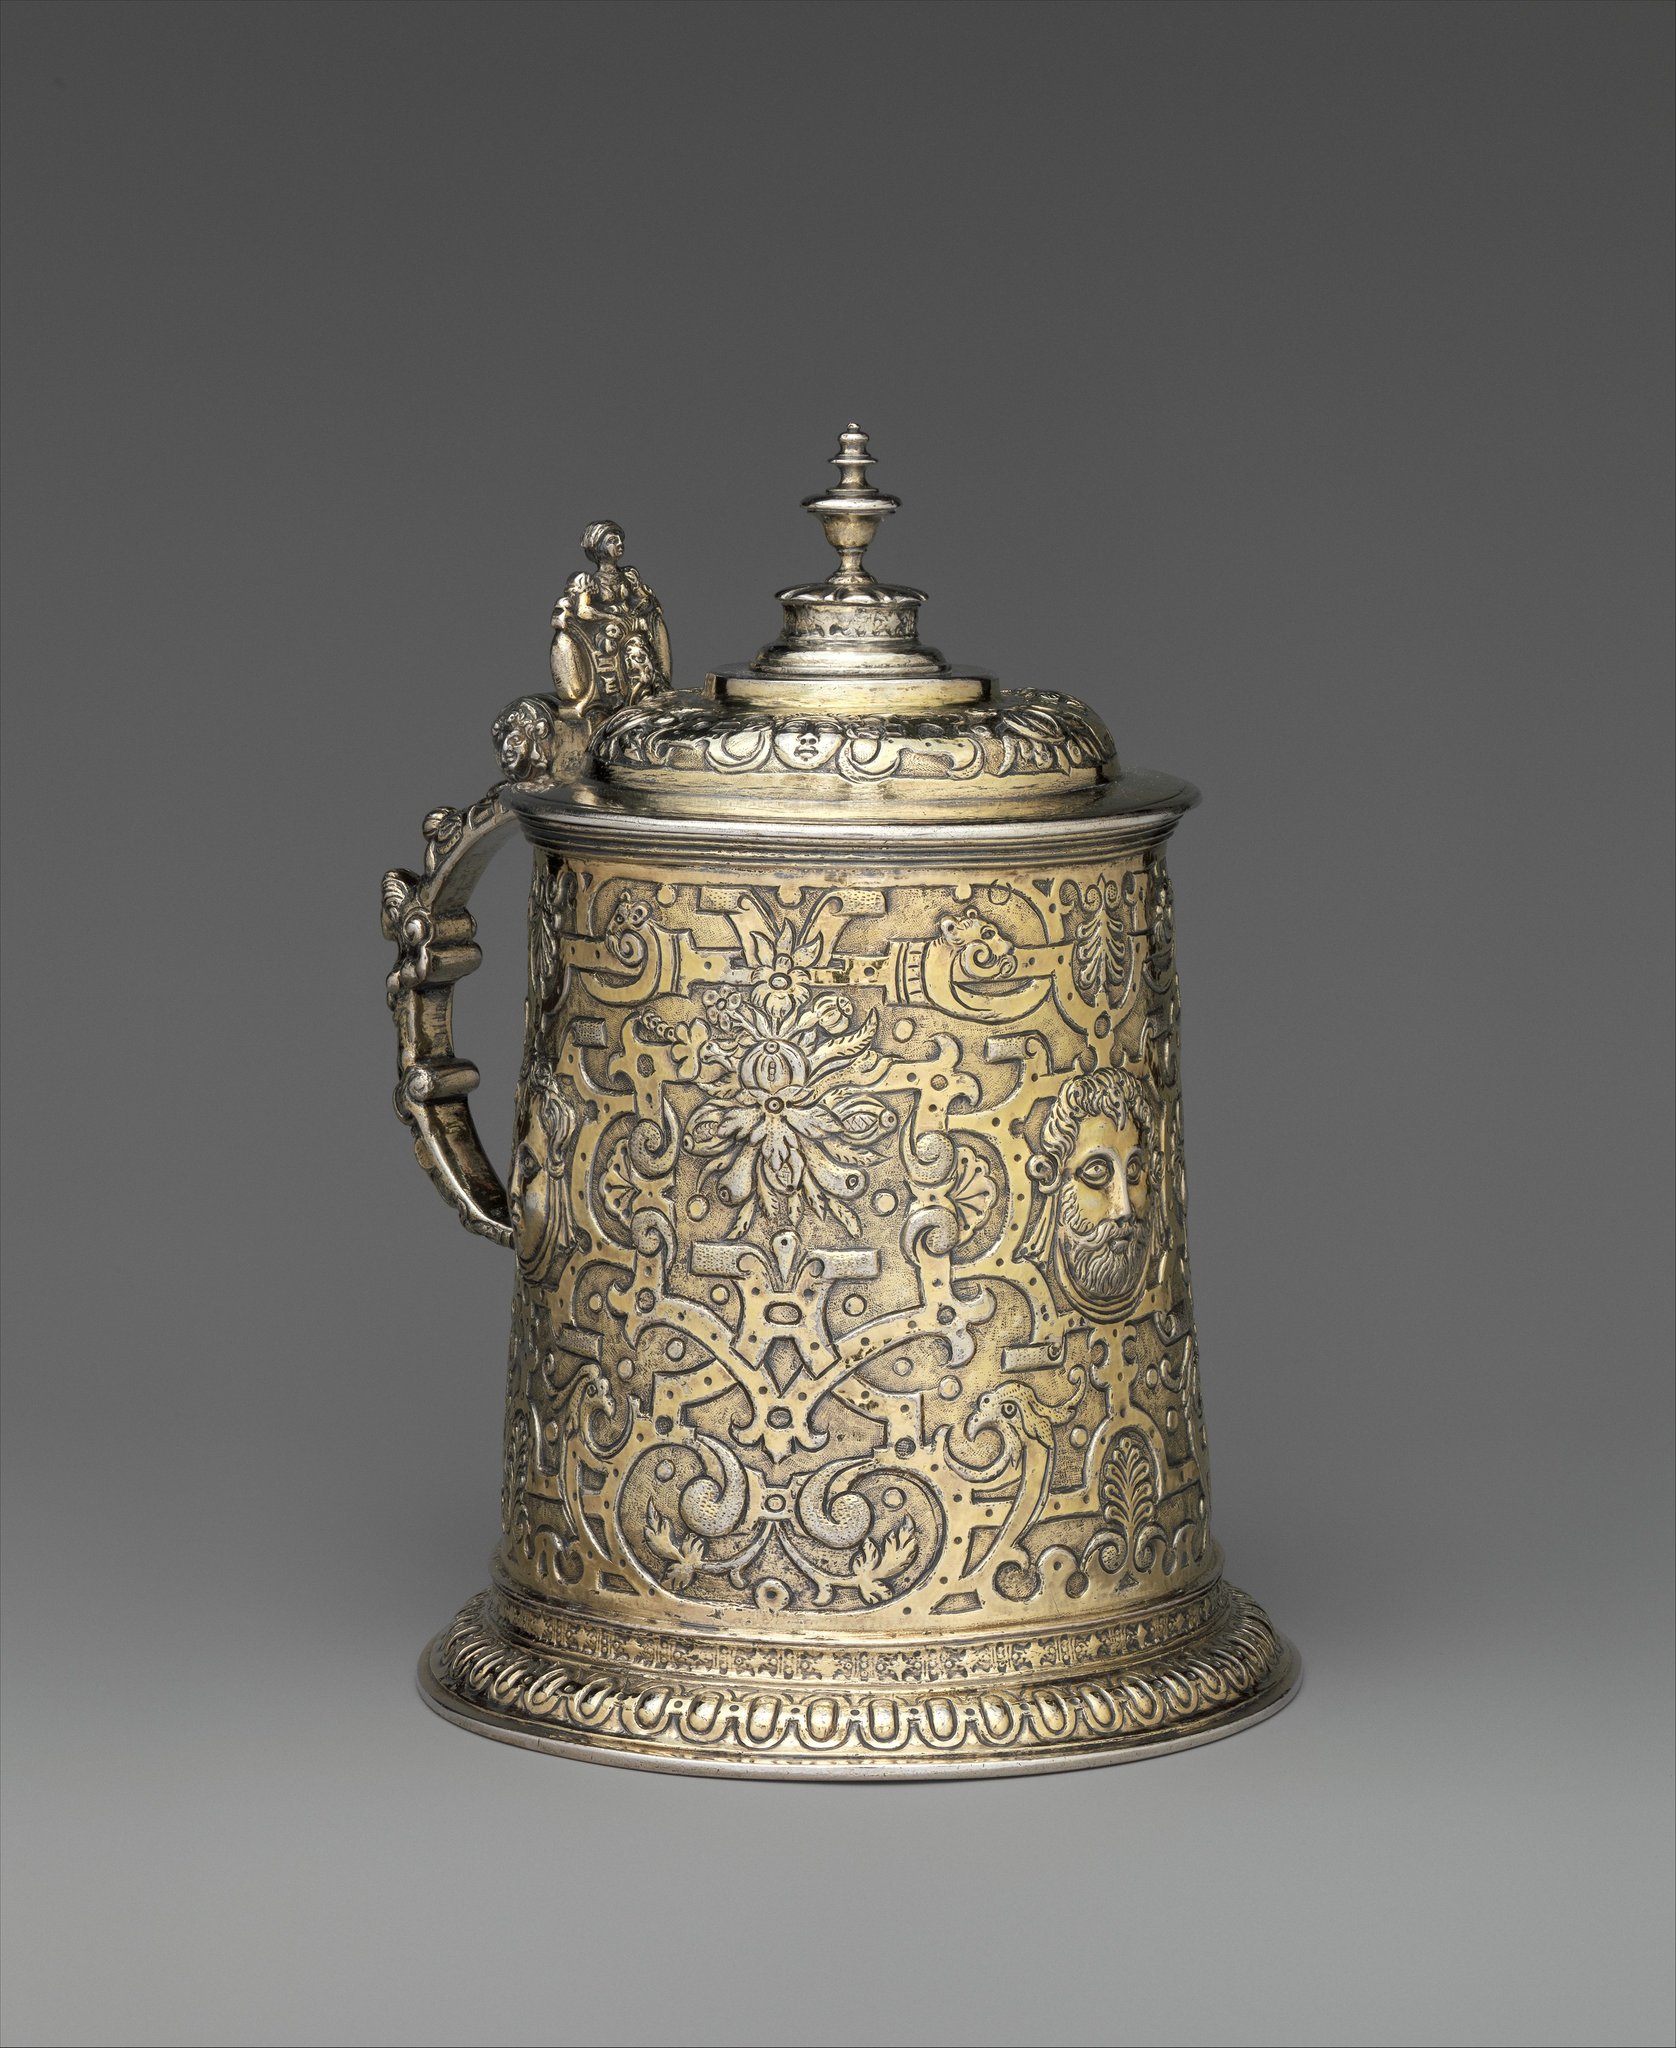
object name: tankard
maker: gregorius gunesch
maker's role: maker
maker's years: 1592-1602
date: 1567-1600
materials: gilt silver